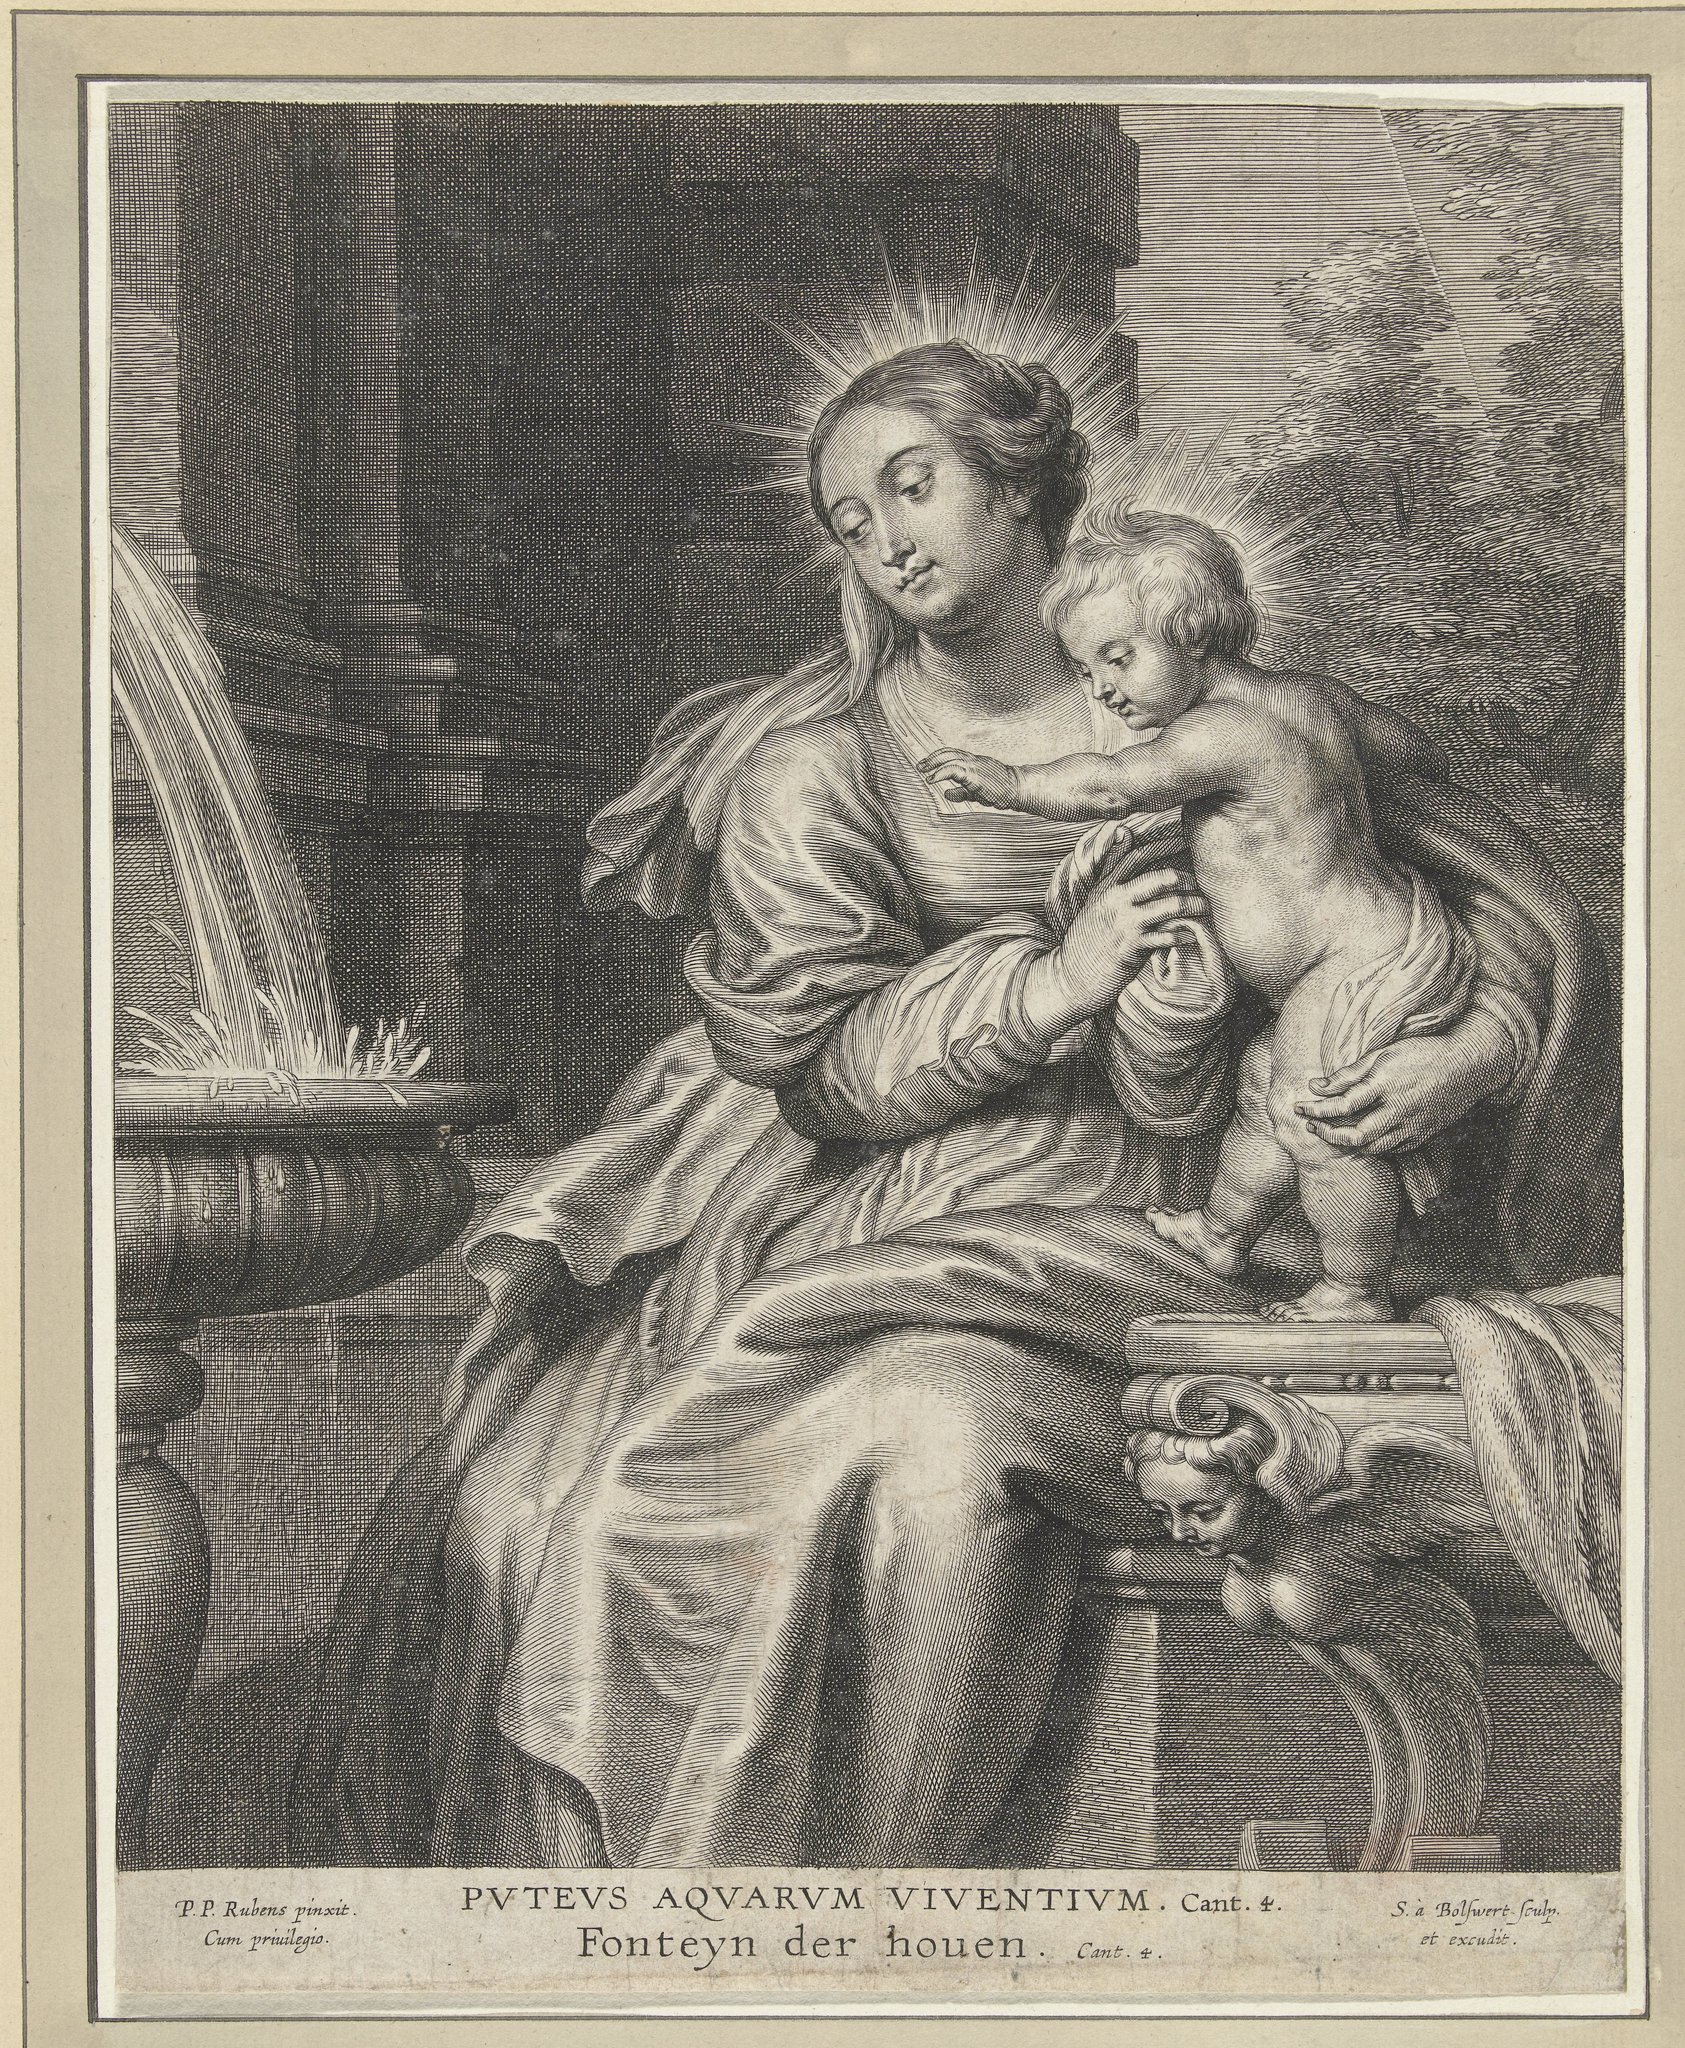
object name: print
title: Maria met kind bij een fontein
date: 1596-1659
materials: paper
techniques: engraving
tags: mary, usually with the christ-child, in orans-position in a fountain (of life)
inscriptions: collector's mark: Lugt 2228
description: Maria zit met kind bij een fontein. Onder de voorstelling staat een regel uit het Hooglied in Latijn en Nederlands, vers 4